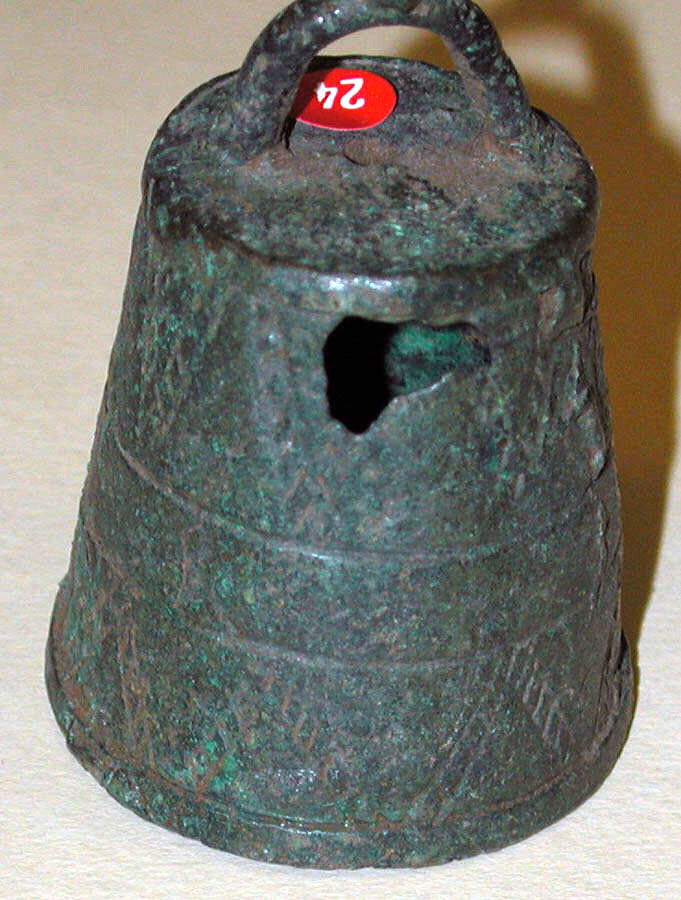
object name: bell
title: Small bell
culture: china or vietnam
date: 500 BCE-300 CE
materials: bronze